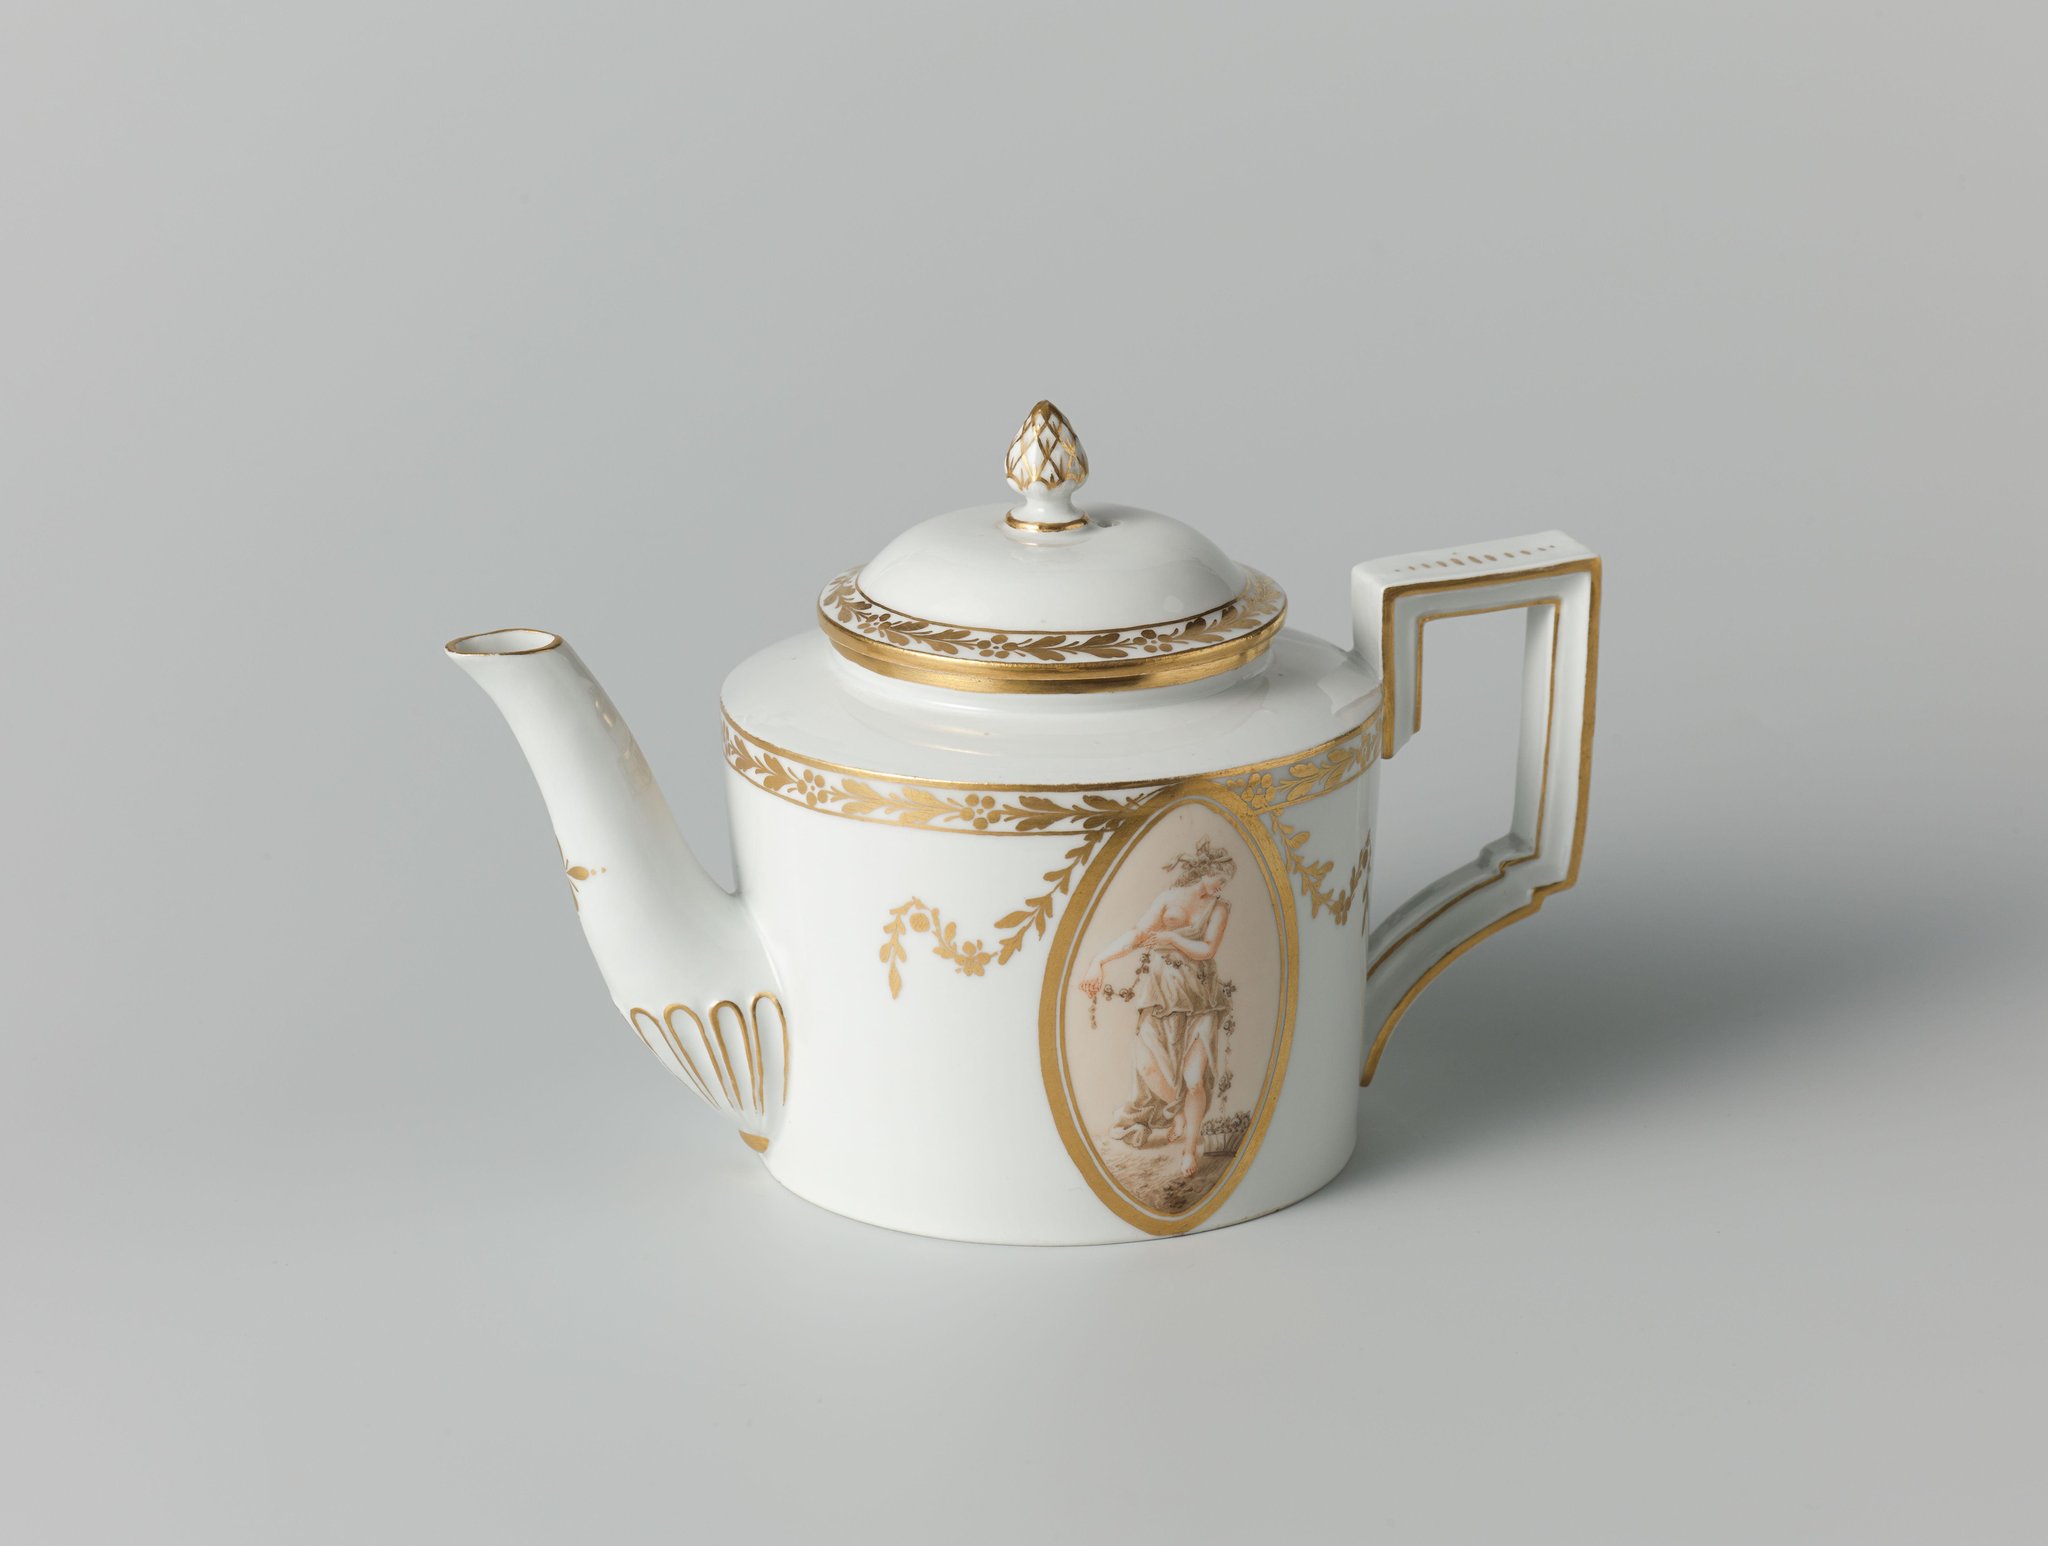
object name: lid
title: Cover of a teapot with a woman in a medallion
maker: carl heinrich böcker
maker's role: porseleinmodelleur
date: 1785-1795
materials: glaze, gold, paint, porcelain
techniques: firing, forming, gilding, turning, vitrification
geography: furstenberg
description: Deksel van theepot, behorend bij een koffie- en theeservies, veelkleurig beschilderd met ovalen waarin vrouwenfiguren of putti in bruin op een grondje tegen een rood fond. Langs de randen een gouden bloem- en bladrank. Gemerkt F met 1, 2, 3 en 10 gescheiden door een liggend streepje in onderglazuurblauw.